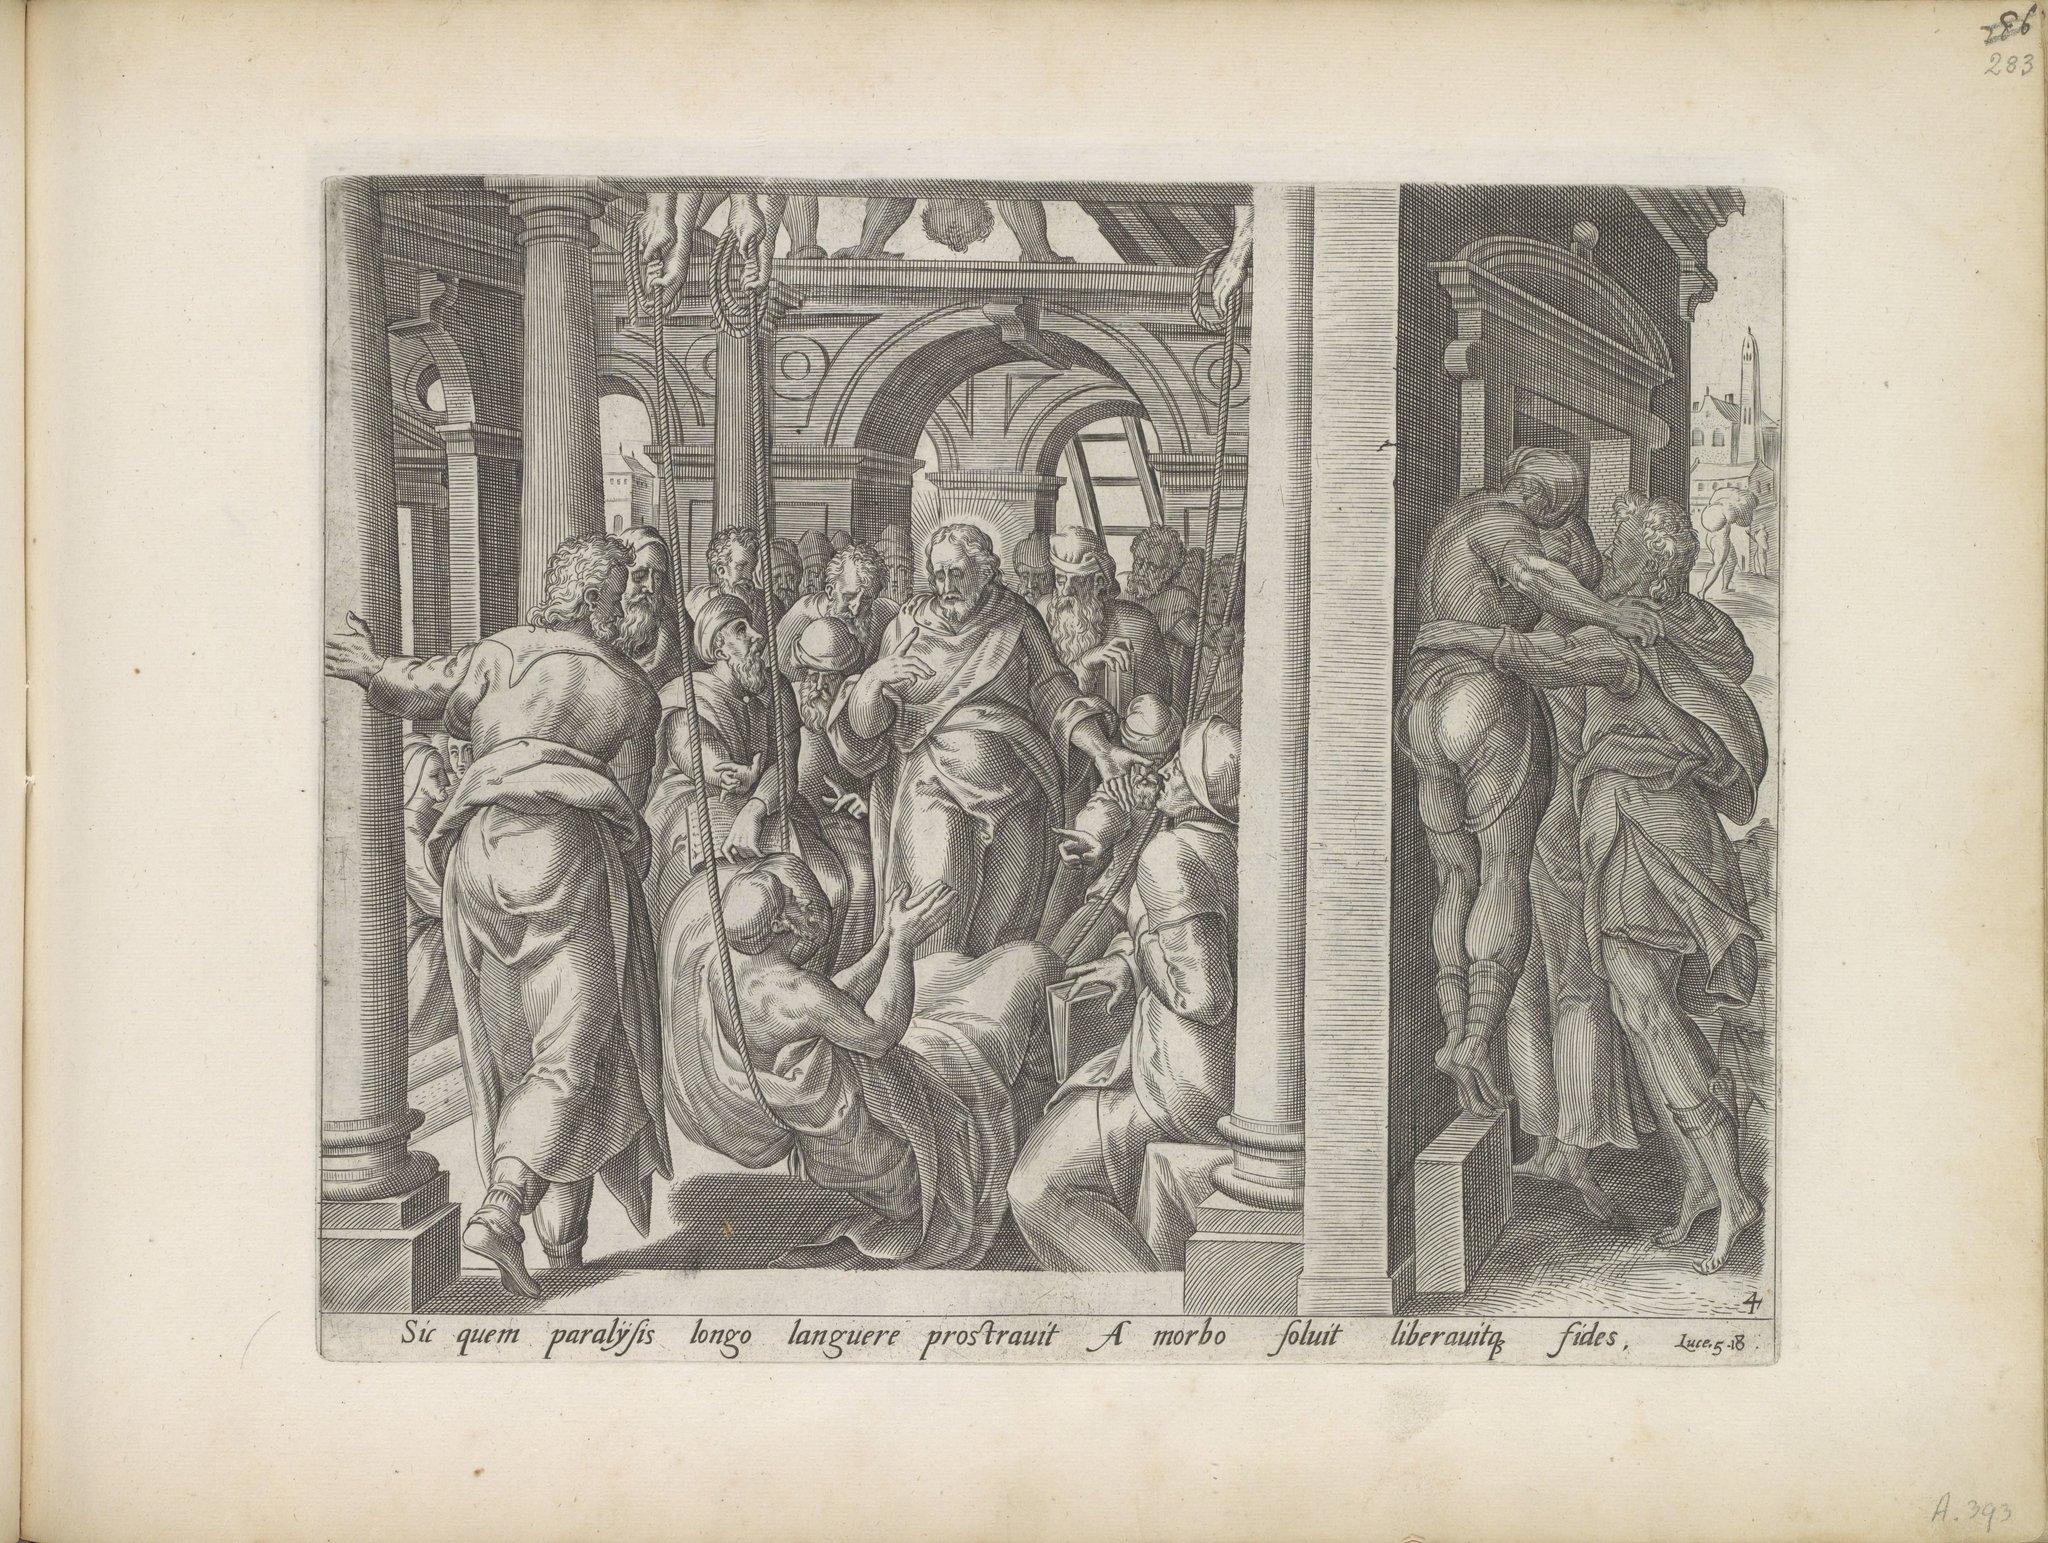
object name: print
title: Christus geneest een verlamde man die door het dak werd neergelaten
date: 1572-1576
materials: paper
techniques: engraving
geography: amsterdam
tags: a paralytic is let down through the roof of the house where christ is preaching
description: Enkele mannen laten een verlamde man op zijn draagbed door een gat in het dak voor de voeten van Christus zakken. Christus vergeeft de zonden van de man en geneest hem. In het gebouw en in de deuropening staan mensen. Onder de voorstelling een verwijzing in het Latijn naar de Bijbeltekst in Luc. 5:18. Deze prent maakt deel uit van een album.